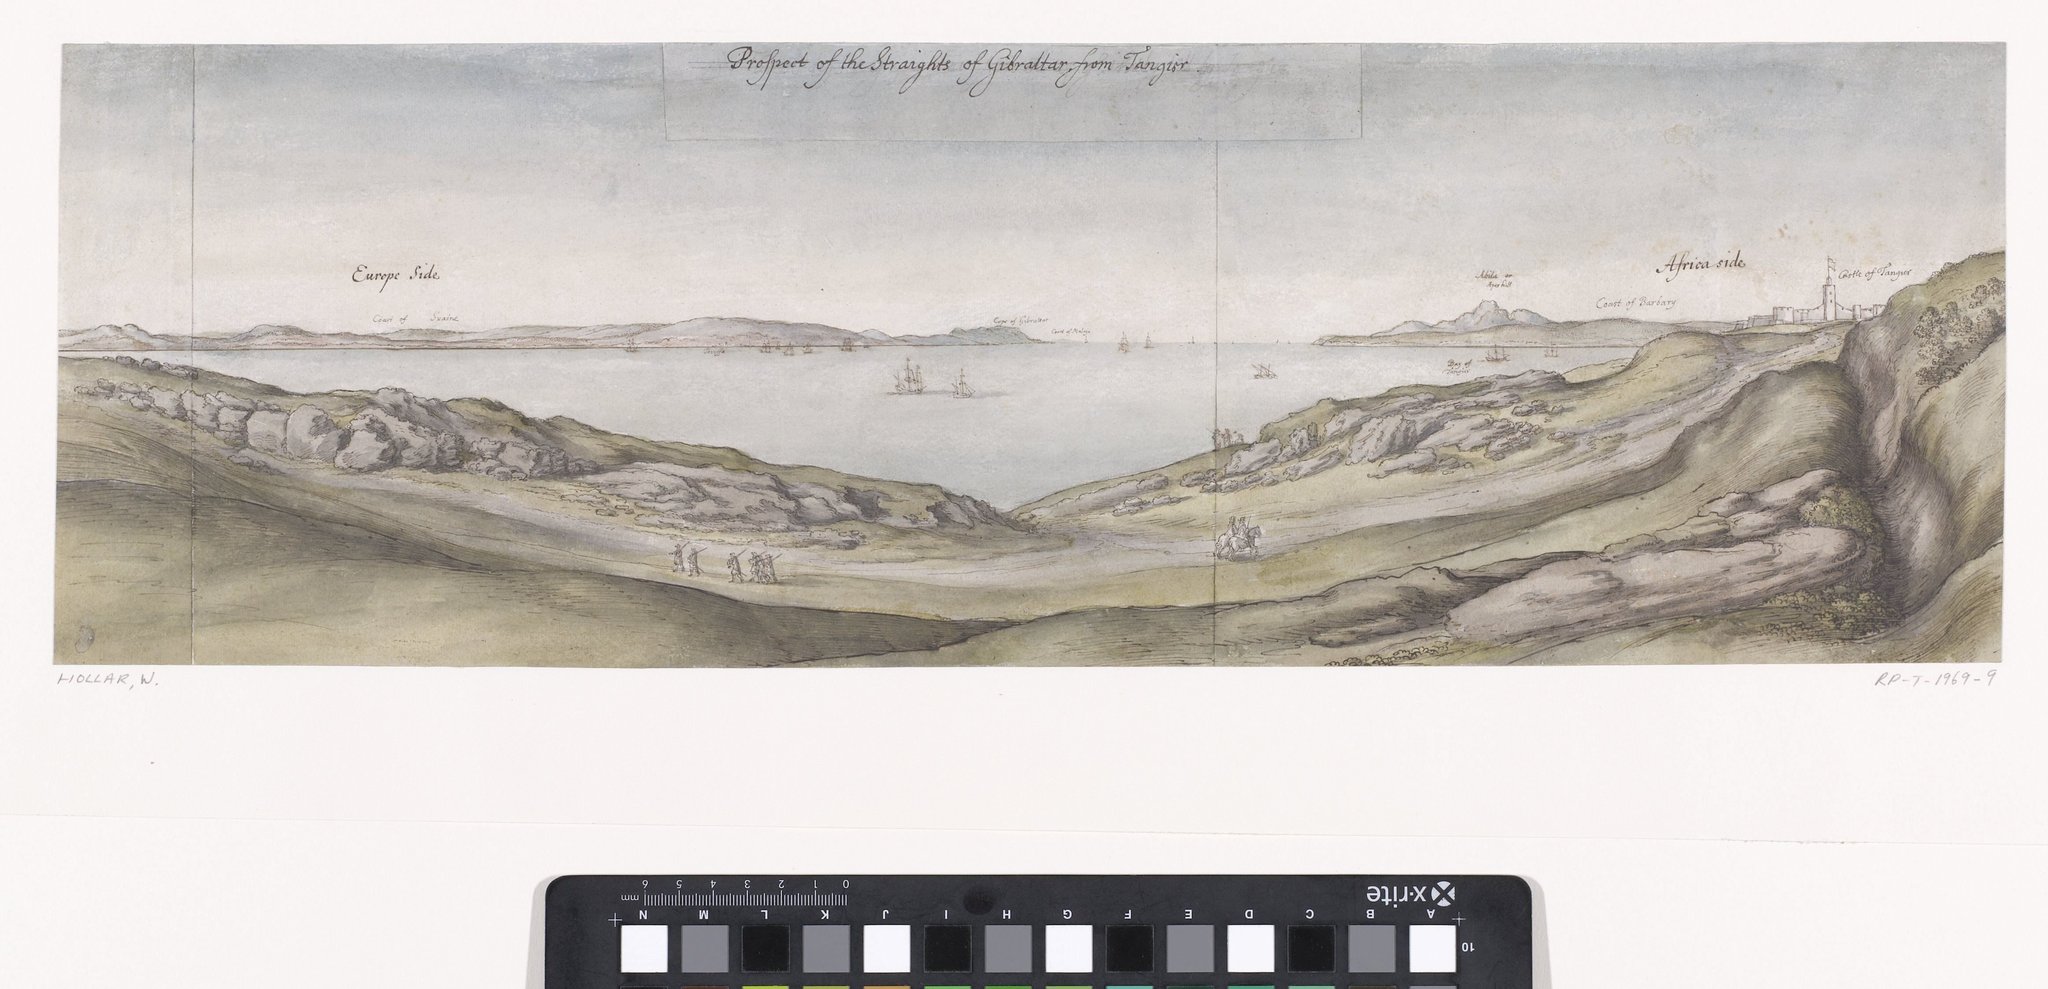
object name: drawing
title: Gezicht op de Straat van Gibraltar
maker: wenceslaus hollar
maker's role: draughtsman, print maker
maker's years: 1607-1677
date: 1668-1669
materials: ink, paper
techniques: brush, pen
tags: coast (+ landscape with figures, staffage)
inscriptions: inscription: ‘Prospect of the Straights of Gibraltar from Tangier’